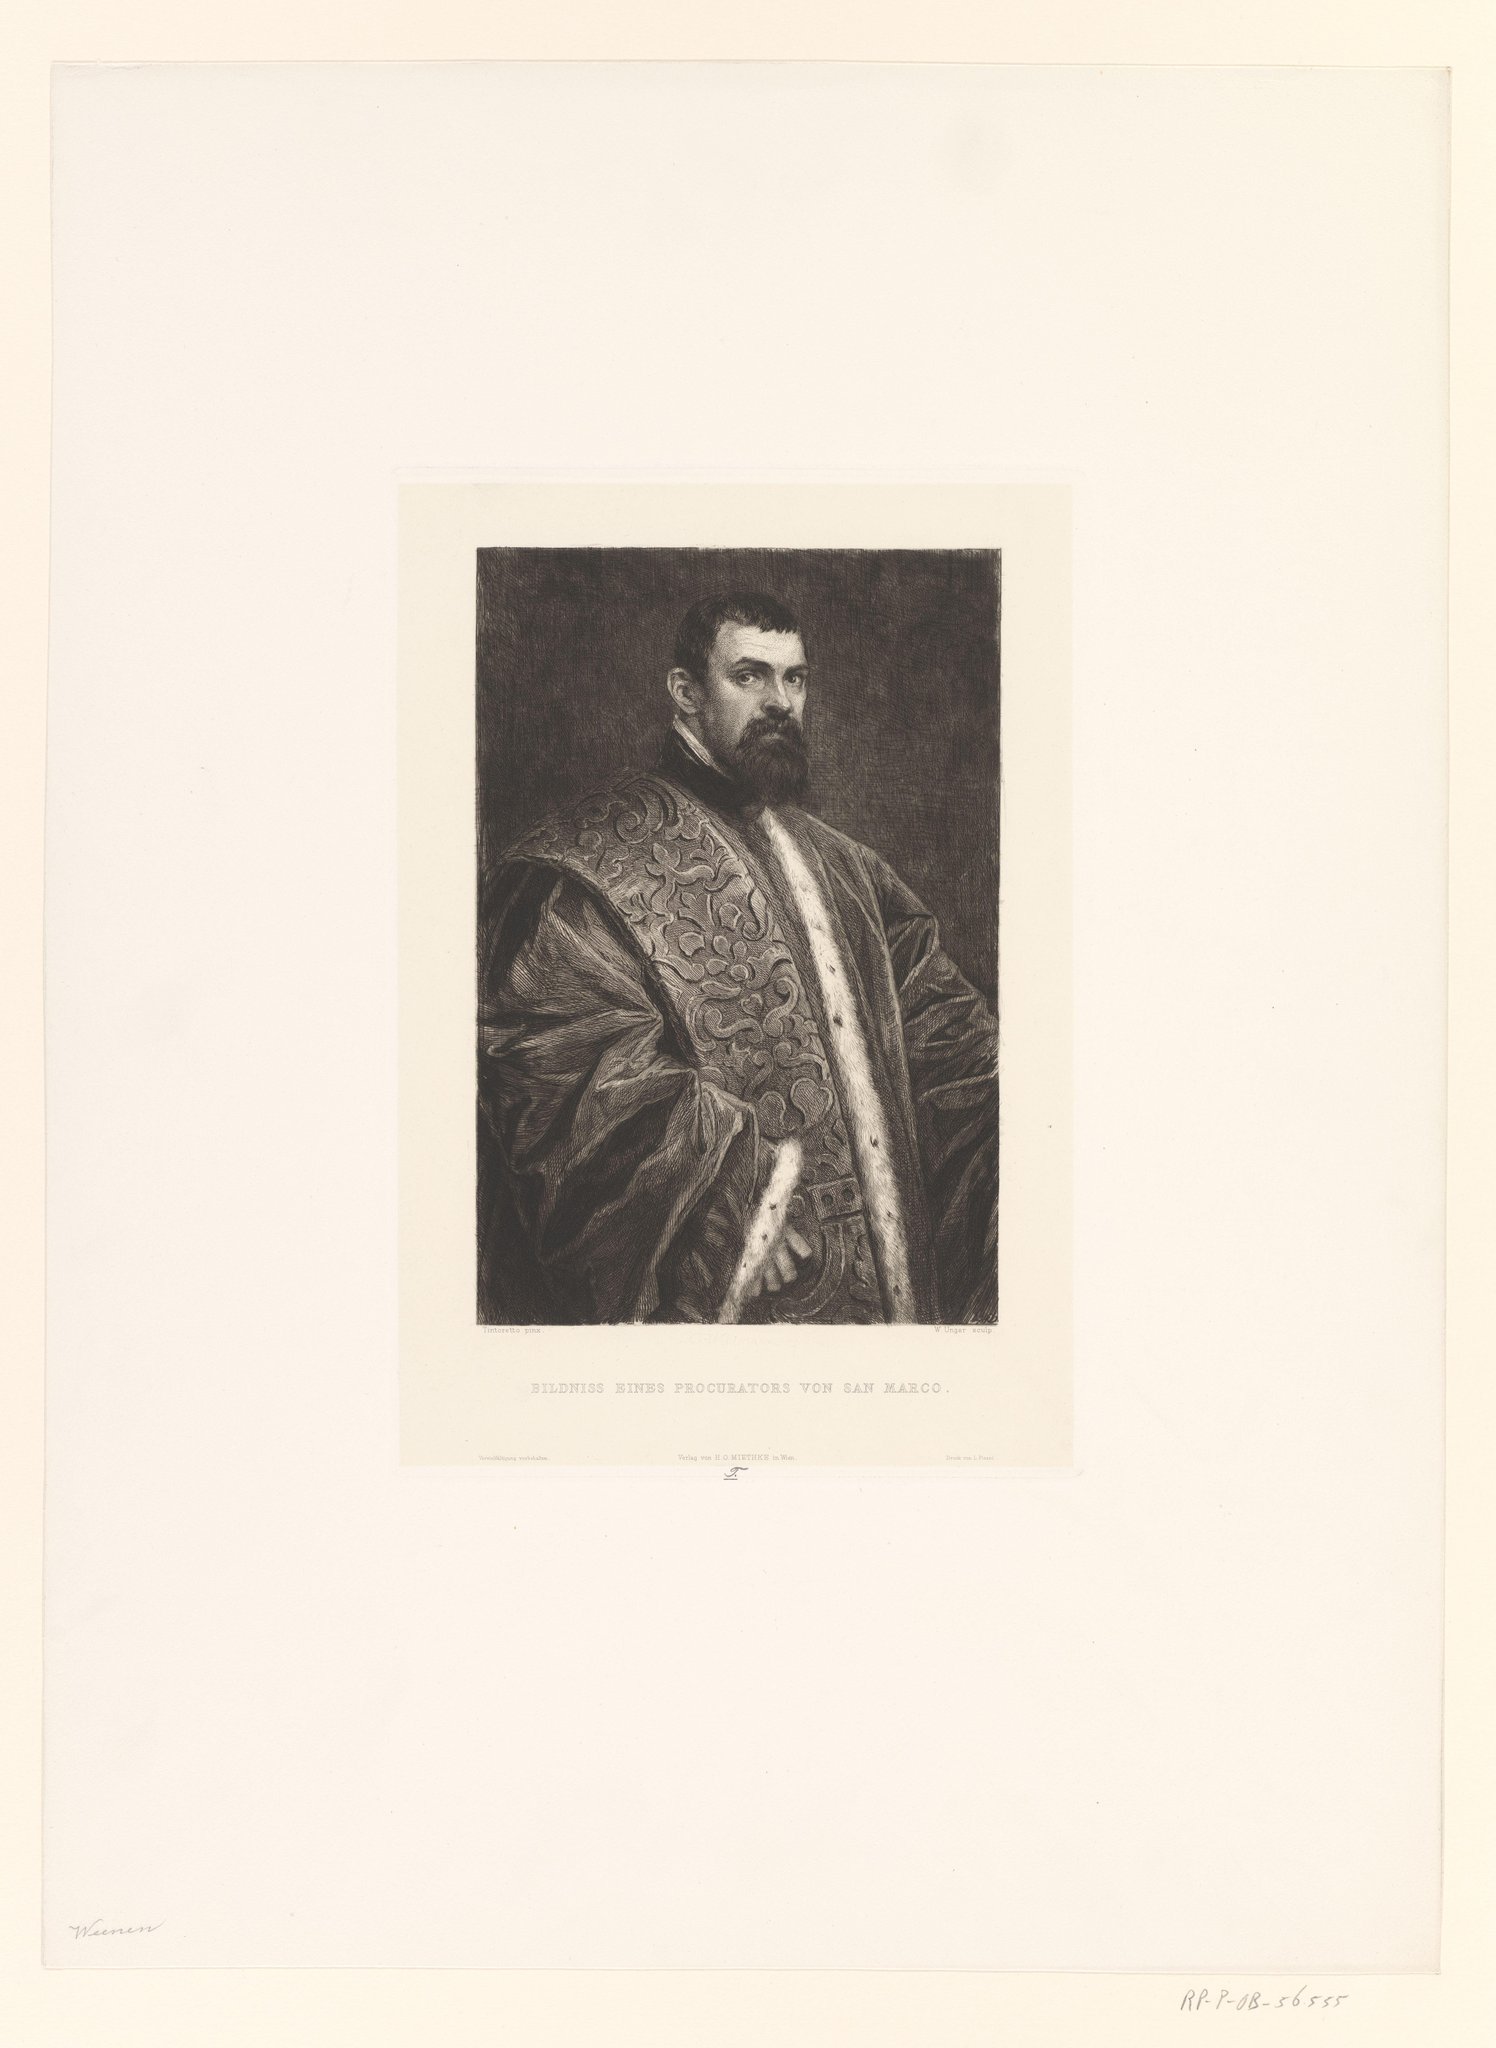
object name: print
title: Portret van een onbekende procurator van San Marco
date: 1861-1889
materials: paper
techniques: etching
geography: vienna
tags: historical persons not known by name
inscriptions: collector's mark: Lugt 2228